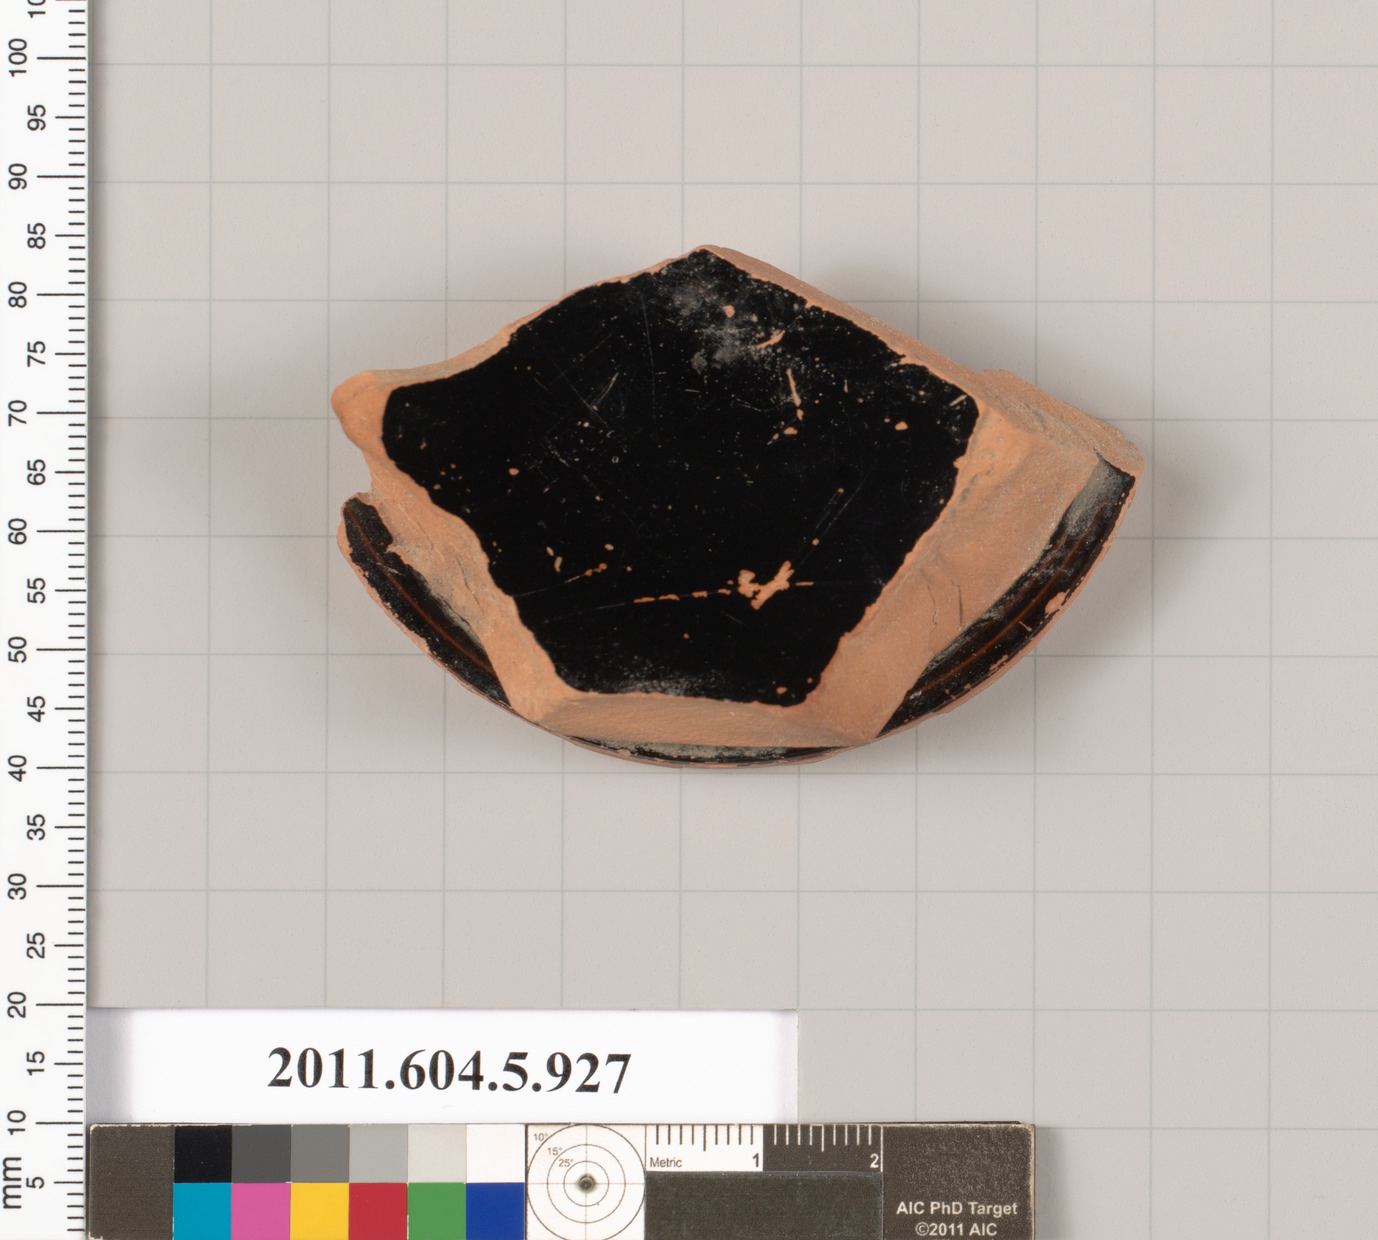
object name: kylix fragment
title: Terracotta fragment of a stemless kylix (drinking cup)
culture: greek, attic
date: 600-401 BCE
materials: terracotta